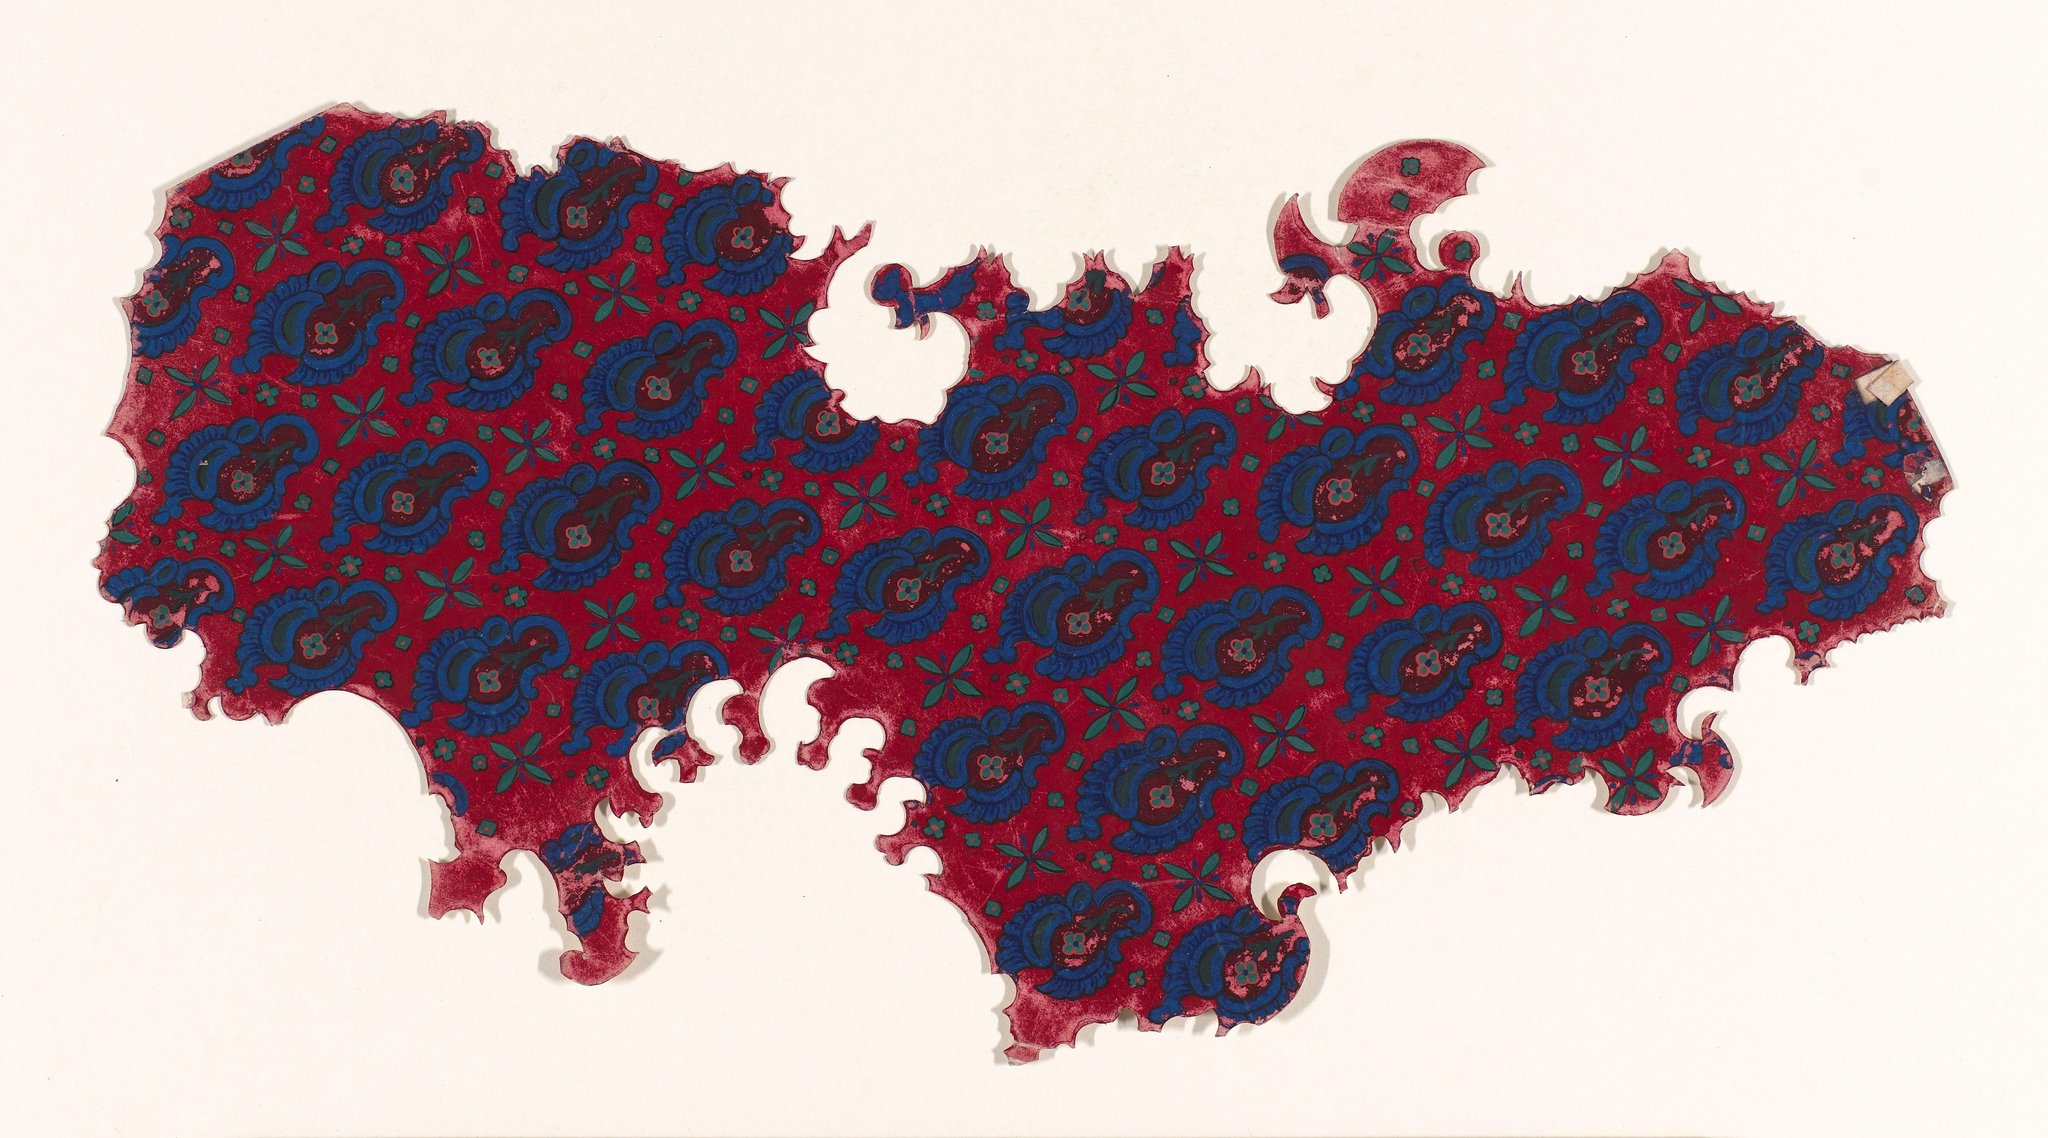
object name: design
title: Fragment van een ontwerp voor een tapijt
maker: Anonymous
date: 1854-1864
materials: gouache, paper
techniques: brush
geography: deventer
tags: ornaments ~ art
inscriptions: retailer's mark: ‘* J.H. SMAALE JR*/ AMSTERDAM.’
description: De presentatietekeningen BK-1971-77-1 t/m 86 zijn kopieën van de originele ontwerptekeningen. Ze werden gemaakt voor vertegenwoordigers van bijvoorbeeld magazijnen, die ze aan hun klanten konden tonen. De meeste tekeningen tonen een kwart van het dessin inclusief rand, middenpartij (de zogenaamde grond of fond) en centraal medaillon. Door het gebruik van spiegels kan de illusie van het gehele tapijt worden opgeroepen. Een deel van de tekeningen heeft een alfabetische opeenvolgende letter als kenmerk, de andere groep een cijfer.Waarschijnlijk is de reeks dessins met een letter eerder samengesteld dan de genummerde tekeningen.